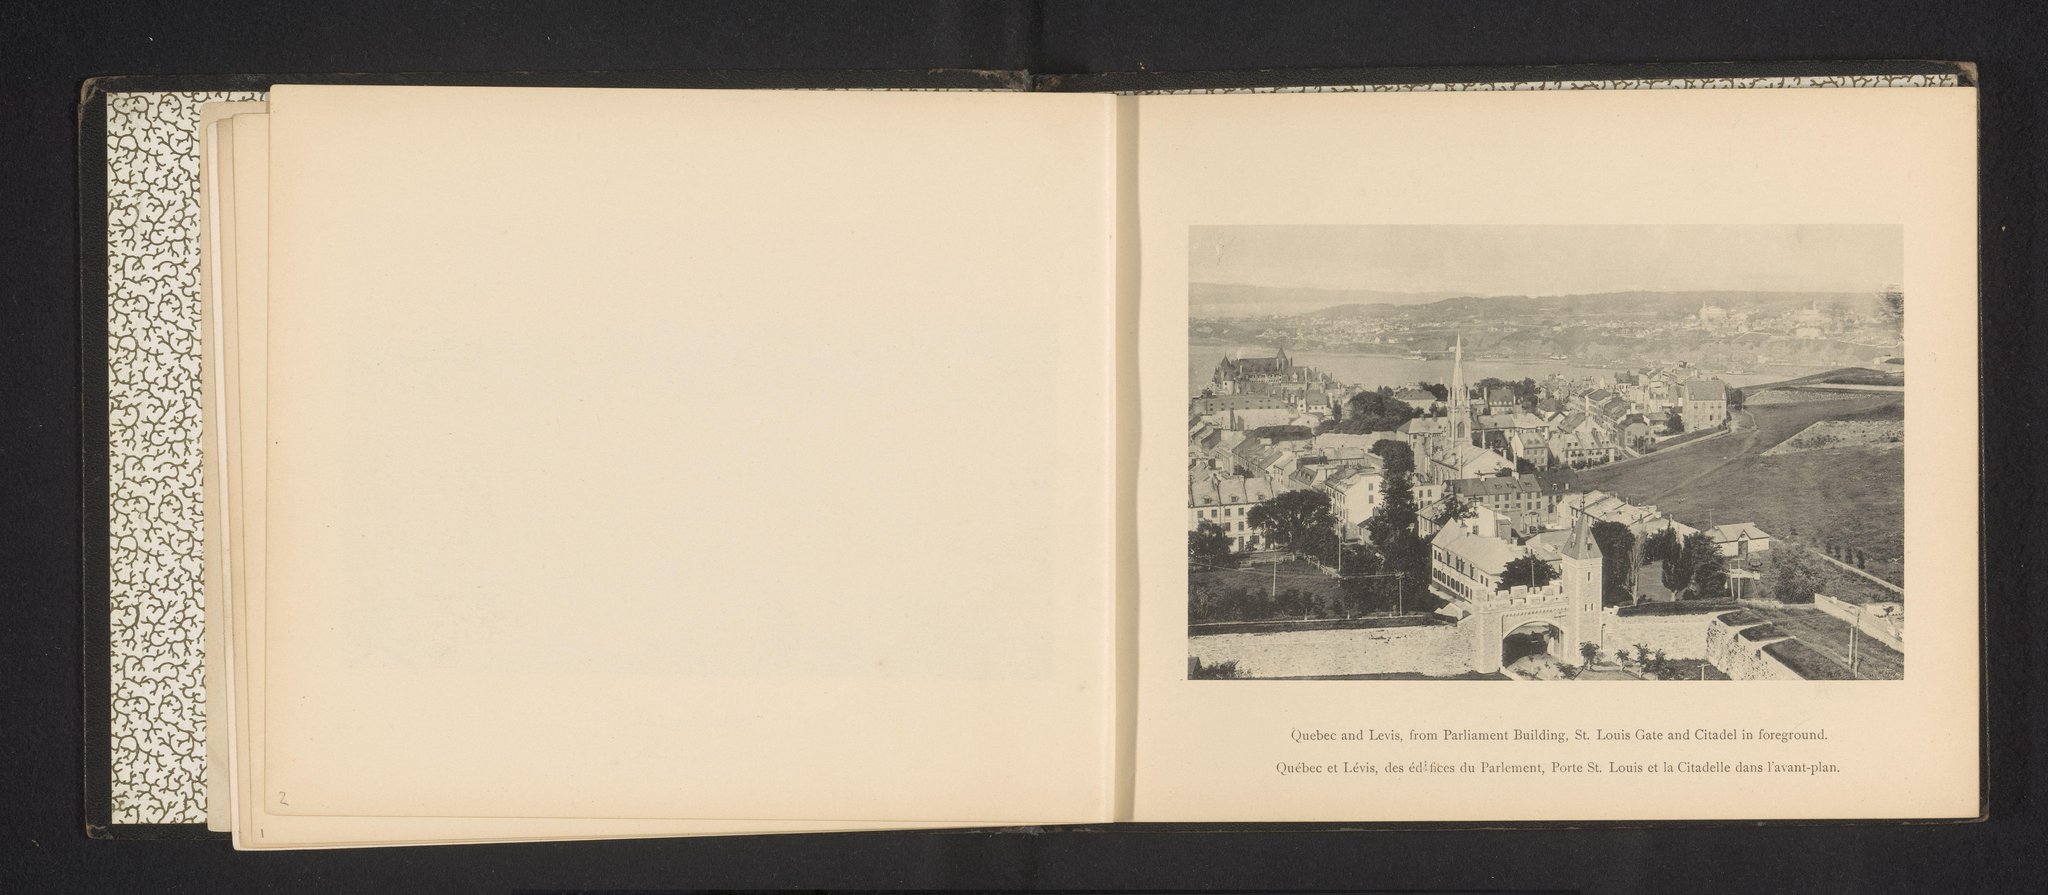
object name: page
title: Gezicht op Québec en Lévis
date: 1889-1894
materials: paper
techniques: photograph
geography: quebec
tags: city-view in general; 'veduta', québec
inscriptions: inscription: ‘Québec and Lévis, from Parliament Building, St. Louis Gate and Citadel in foreground/ Québec et Lévis, des édifices du Parlement, Porte St. Louis et la Citadelle dans l'avant-plan.’